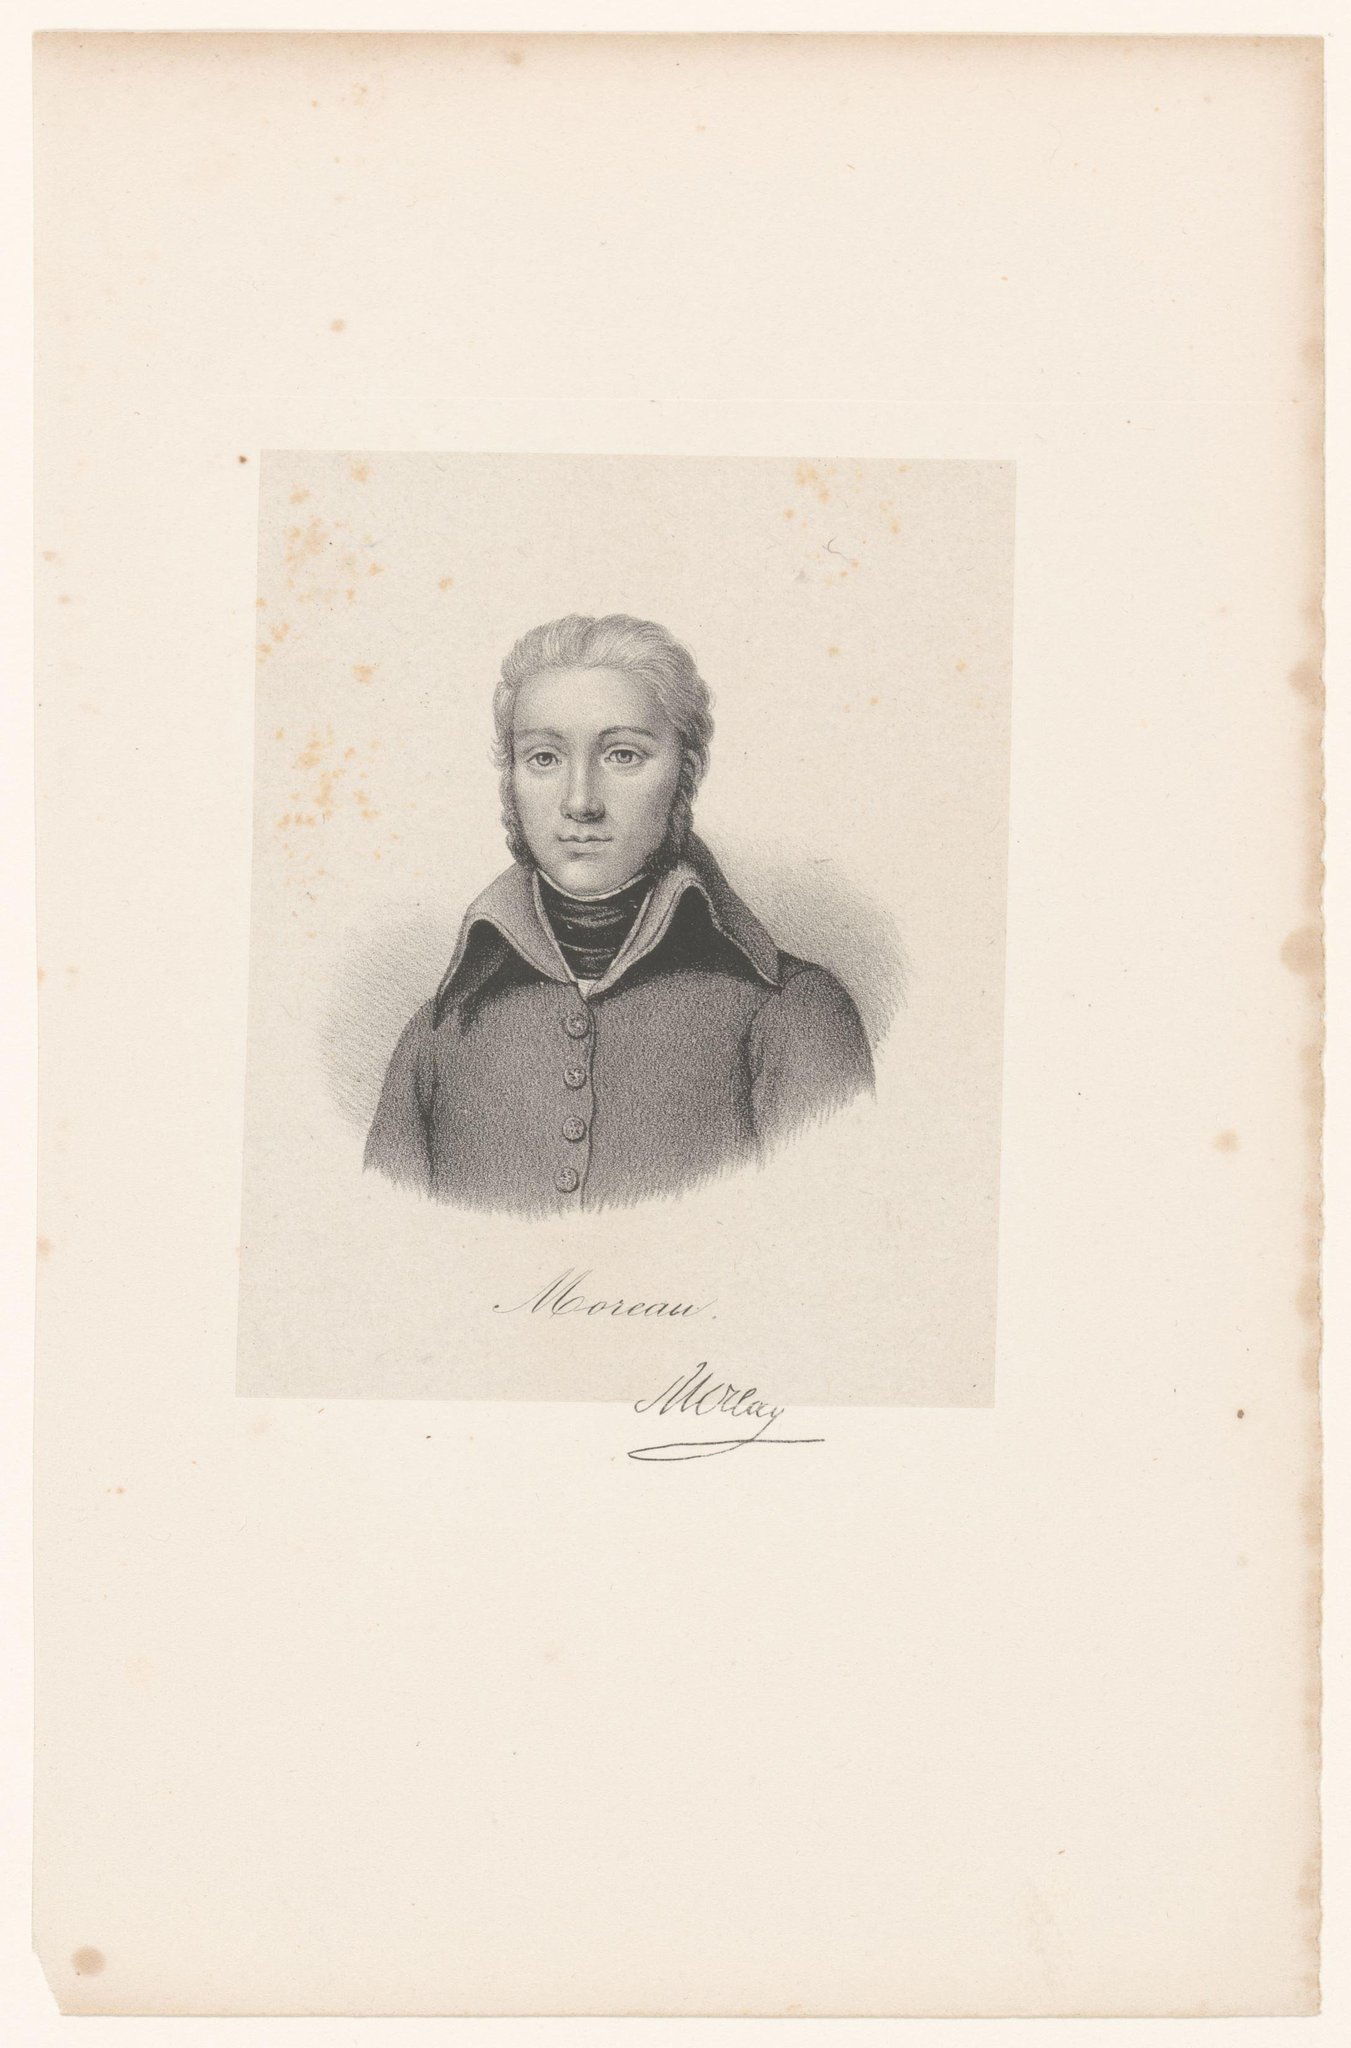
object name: print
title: Moreau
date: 1818-1842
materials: paper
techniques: lithograph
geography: paris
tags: historical persons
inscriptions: collector's mark: Lugt 2228a